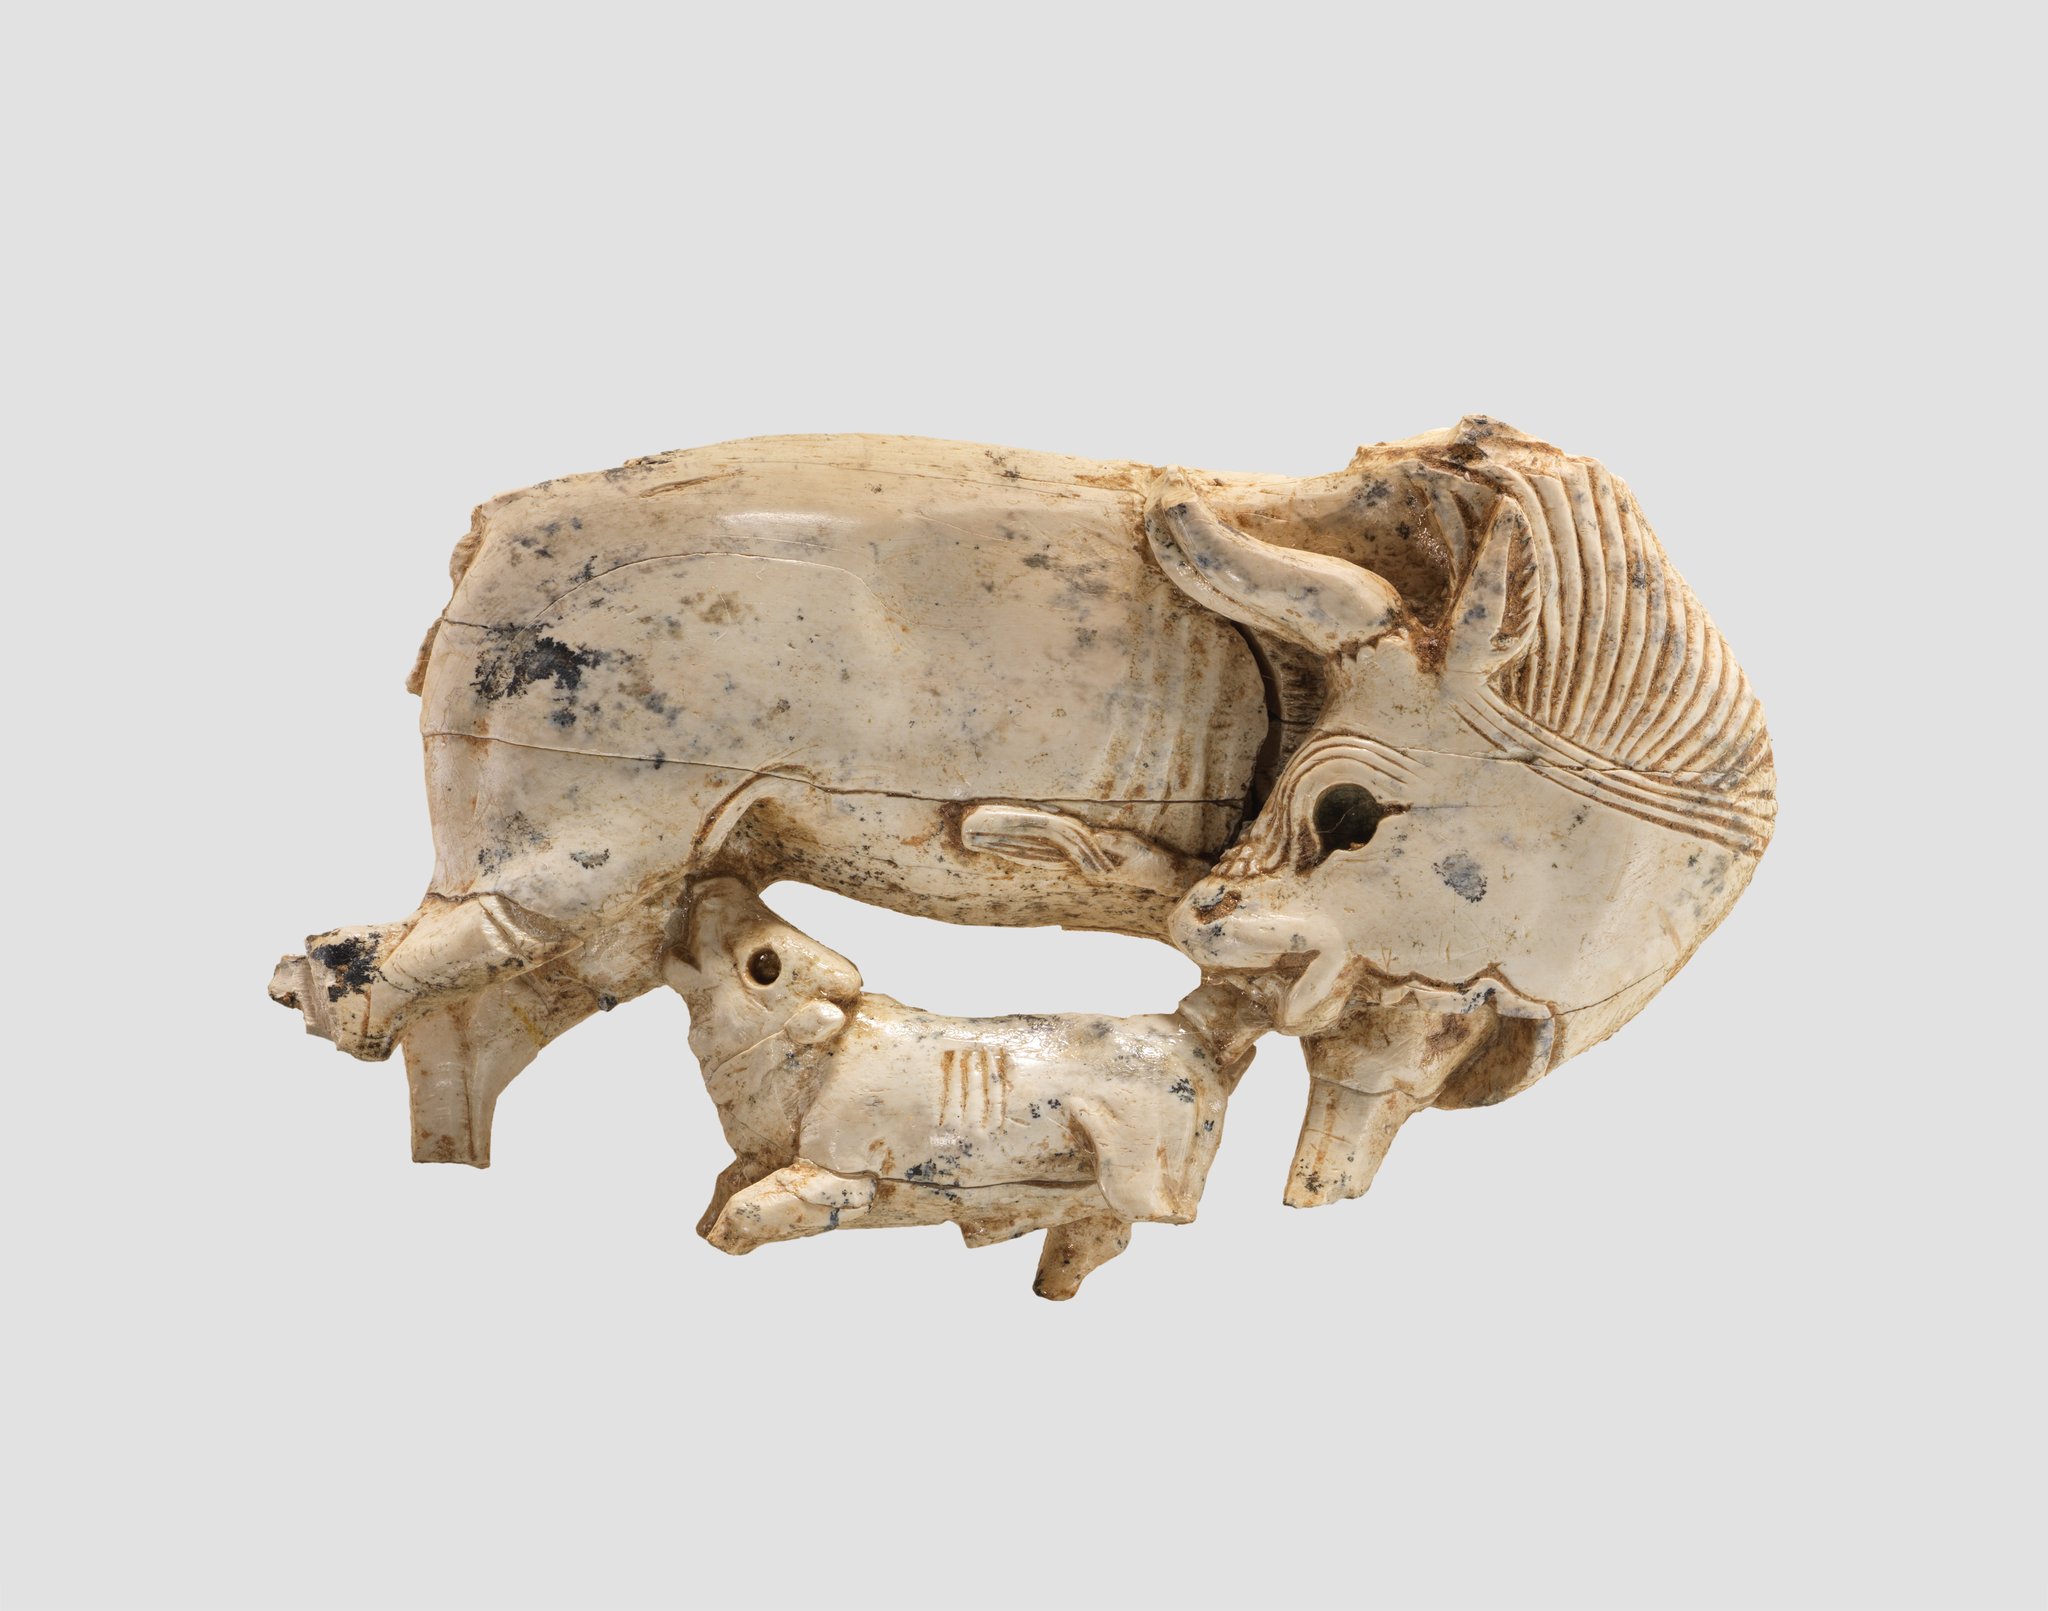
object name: relief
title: Openwork furniture plaque with a cow suckling a calf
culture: assyrian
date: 900-701 BCE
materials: ivory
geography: mesopotamia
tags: cows